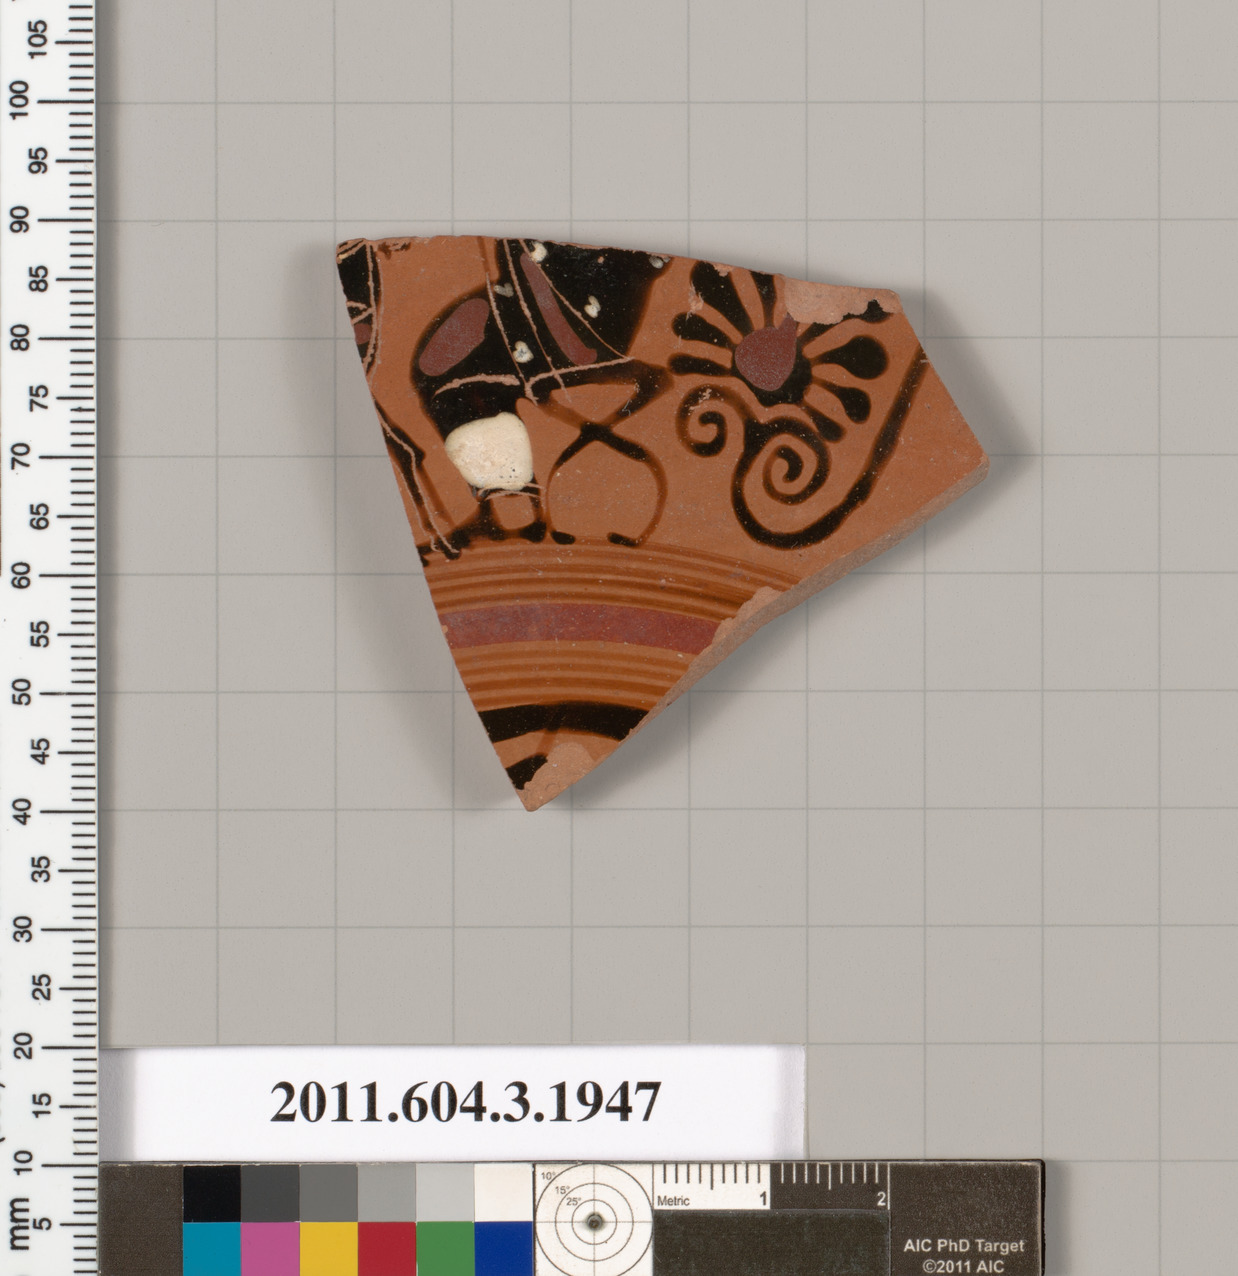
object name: kylix fragment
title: Terracotta fragment of a kylix: Cassel cup (drinking cup)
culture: greek, attic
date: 550-526 BCE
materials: terracotta